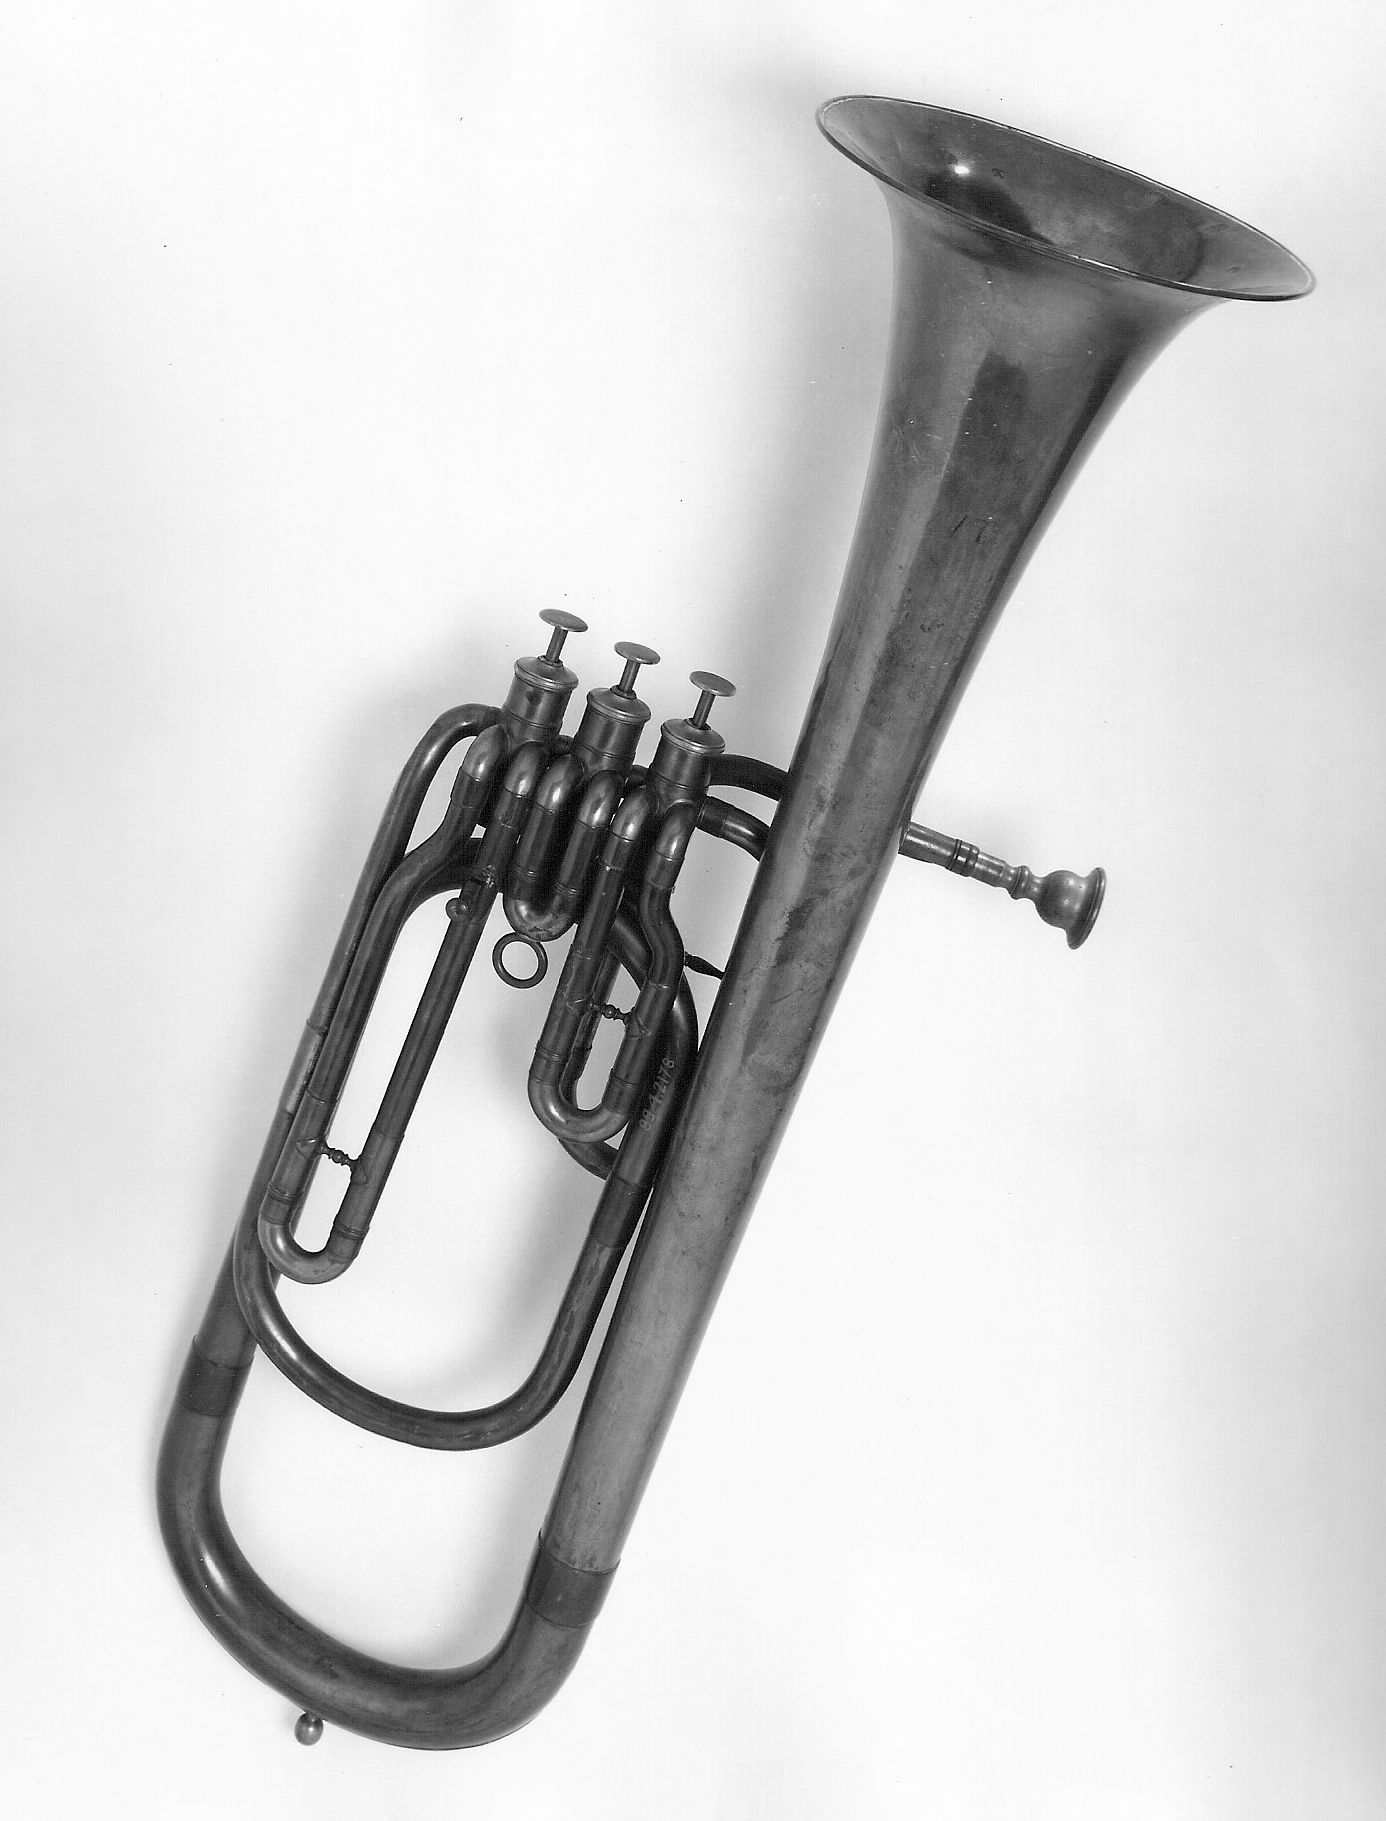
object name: soprano saxhorn in b flat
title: Baritone Saxhorn in B-flat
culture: french or german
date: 1850-1879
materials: brass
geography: france or germany